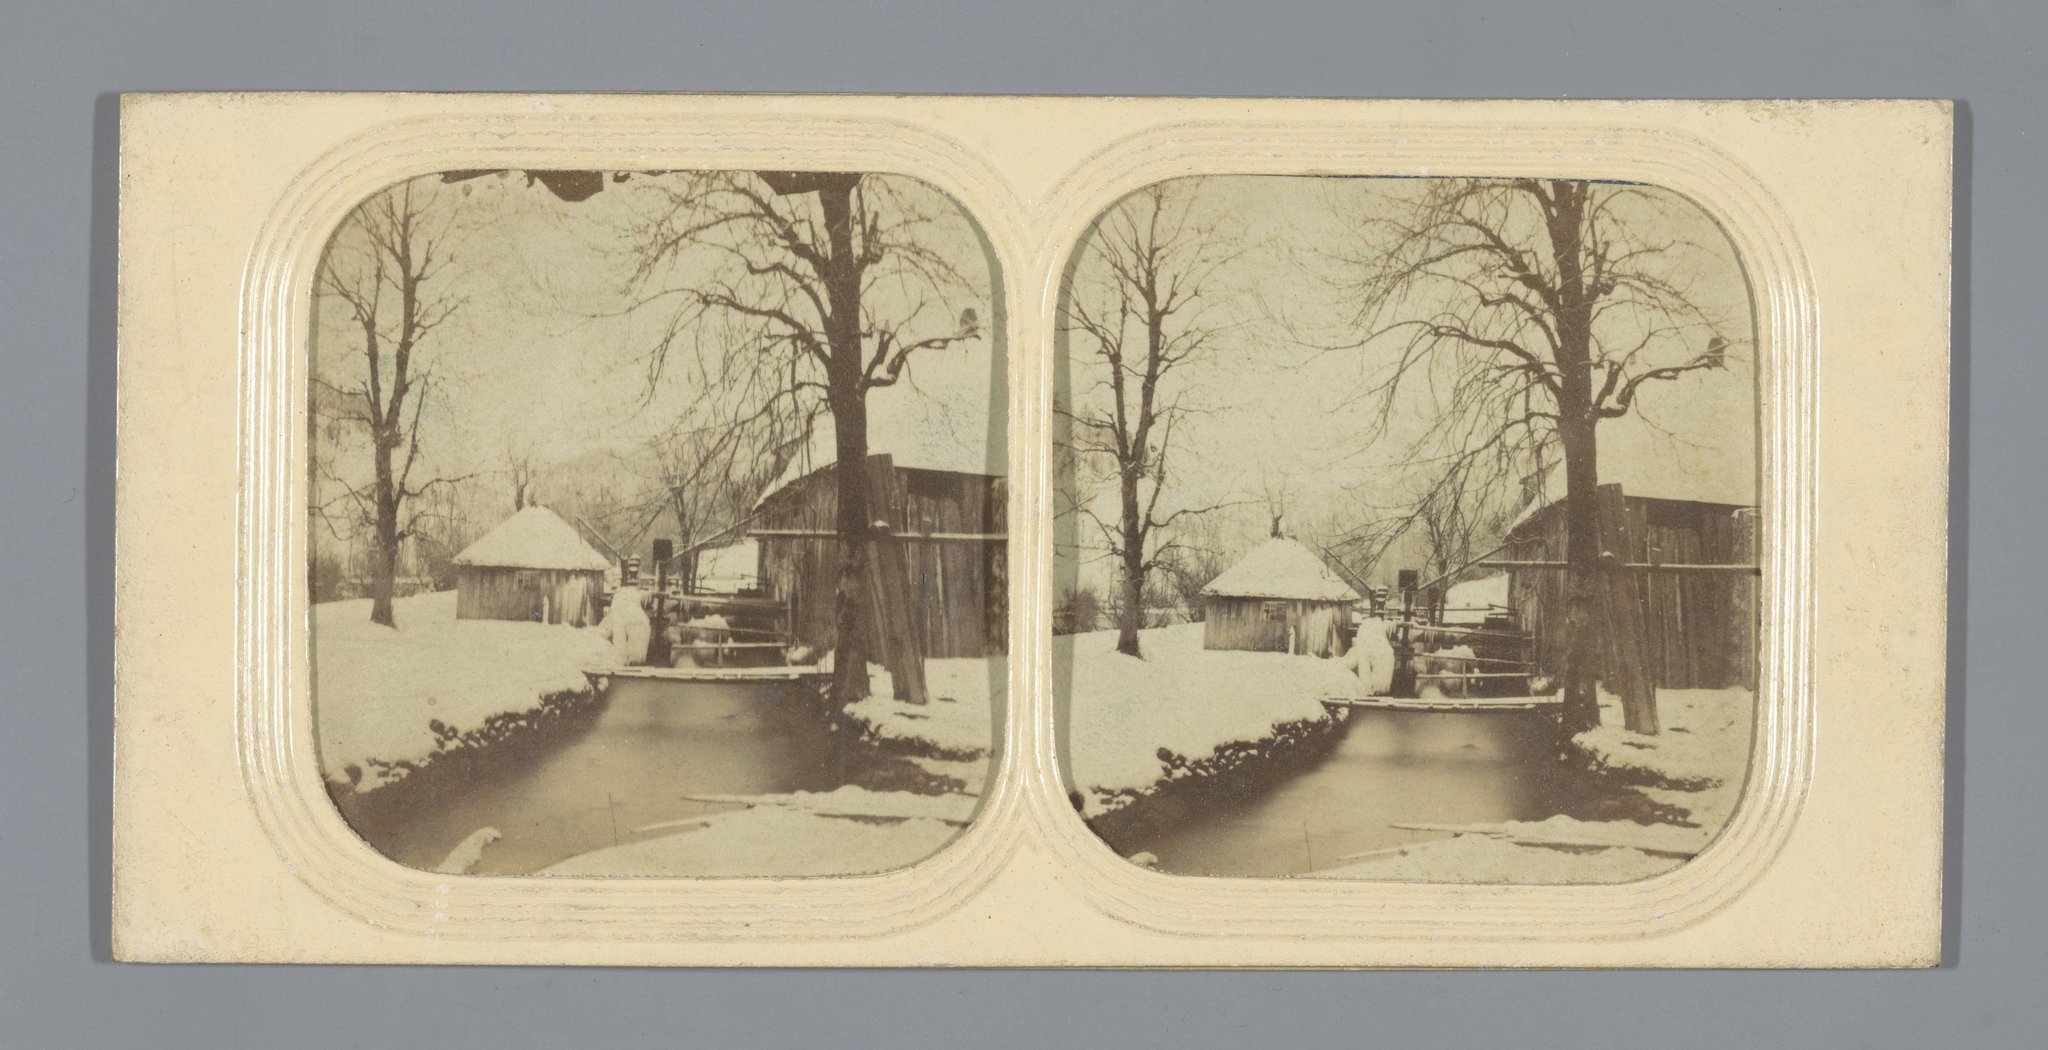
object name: tissue stereograph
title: Besneeuwd dorpsgezicht in de Jura, Zwitserland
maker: Anonymous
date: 1855-1875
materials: cardboard, paper, photographic support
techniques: albumen print, cutting, hand coloring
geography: jura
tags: village, brook, snow